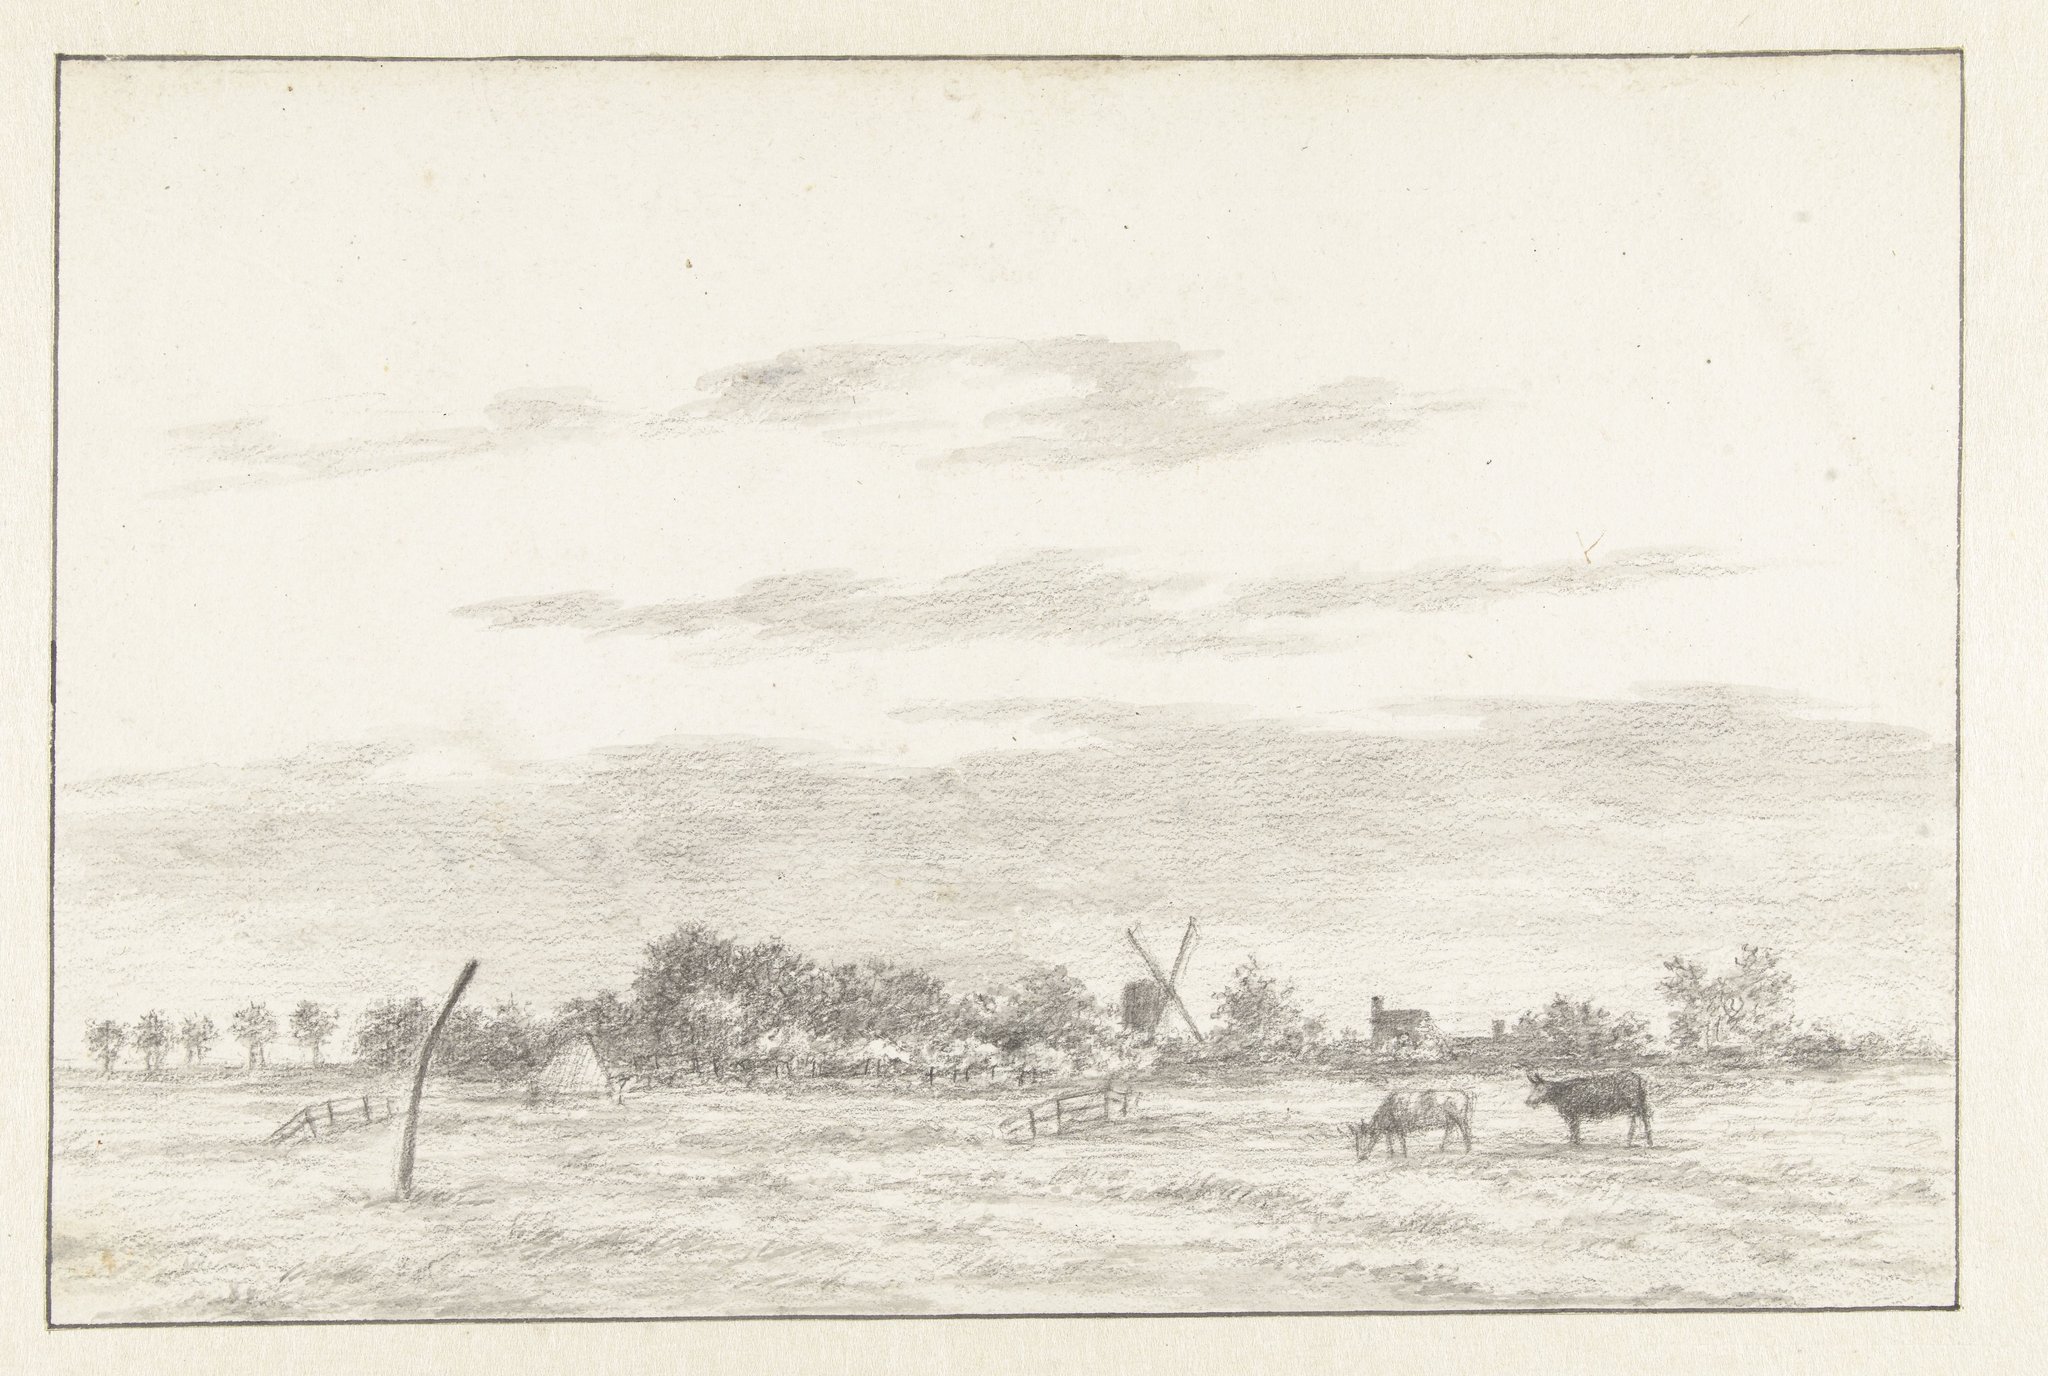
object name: drawing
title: Gezicht op Schalkwijk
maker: pieter bouman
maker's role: draughtsman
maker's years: 1764-1828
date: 1774-1828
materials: chalk, paper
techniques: brush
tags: village, windmill in landscape